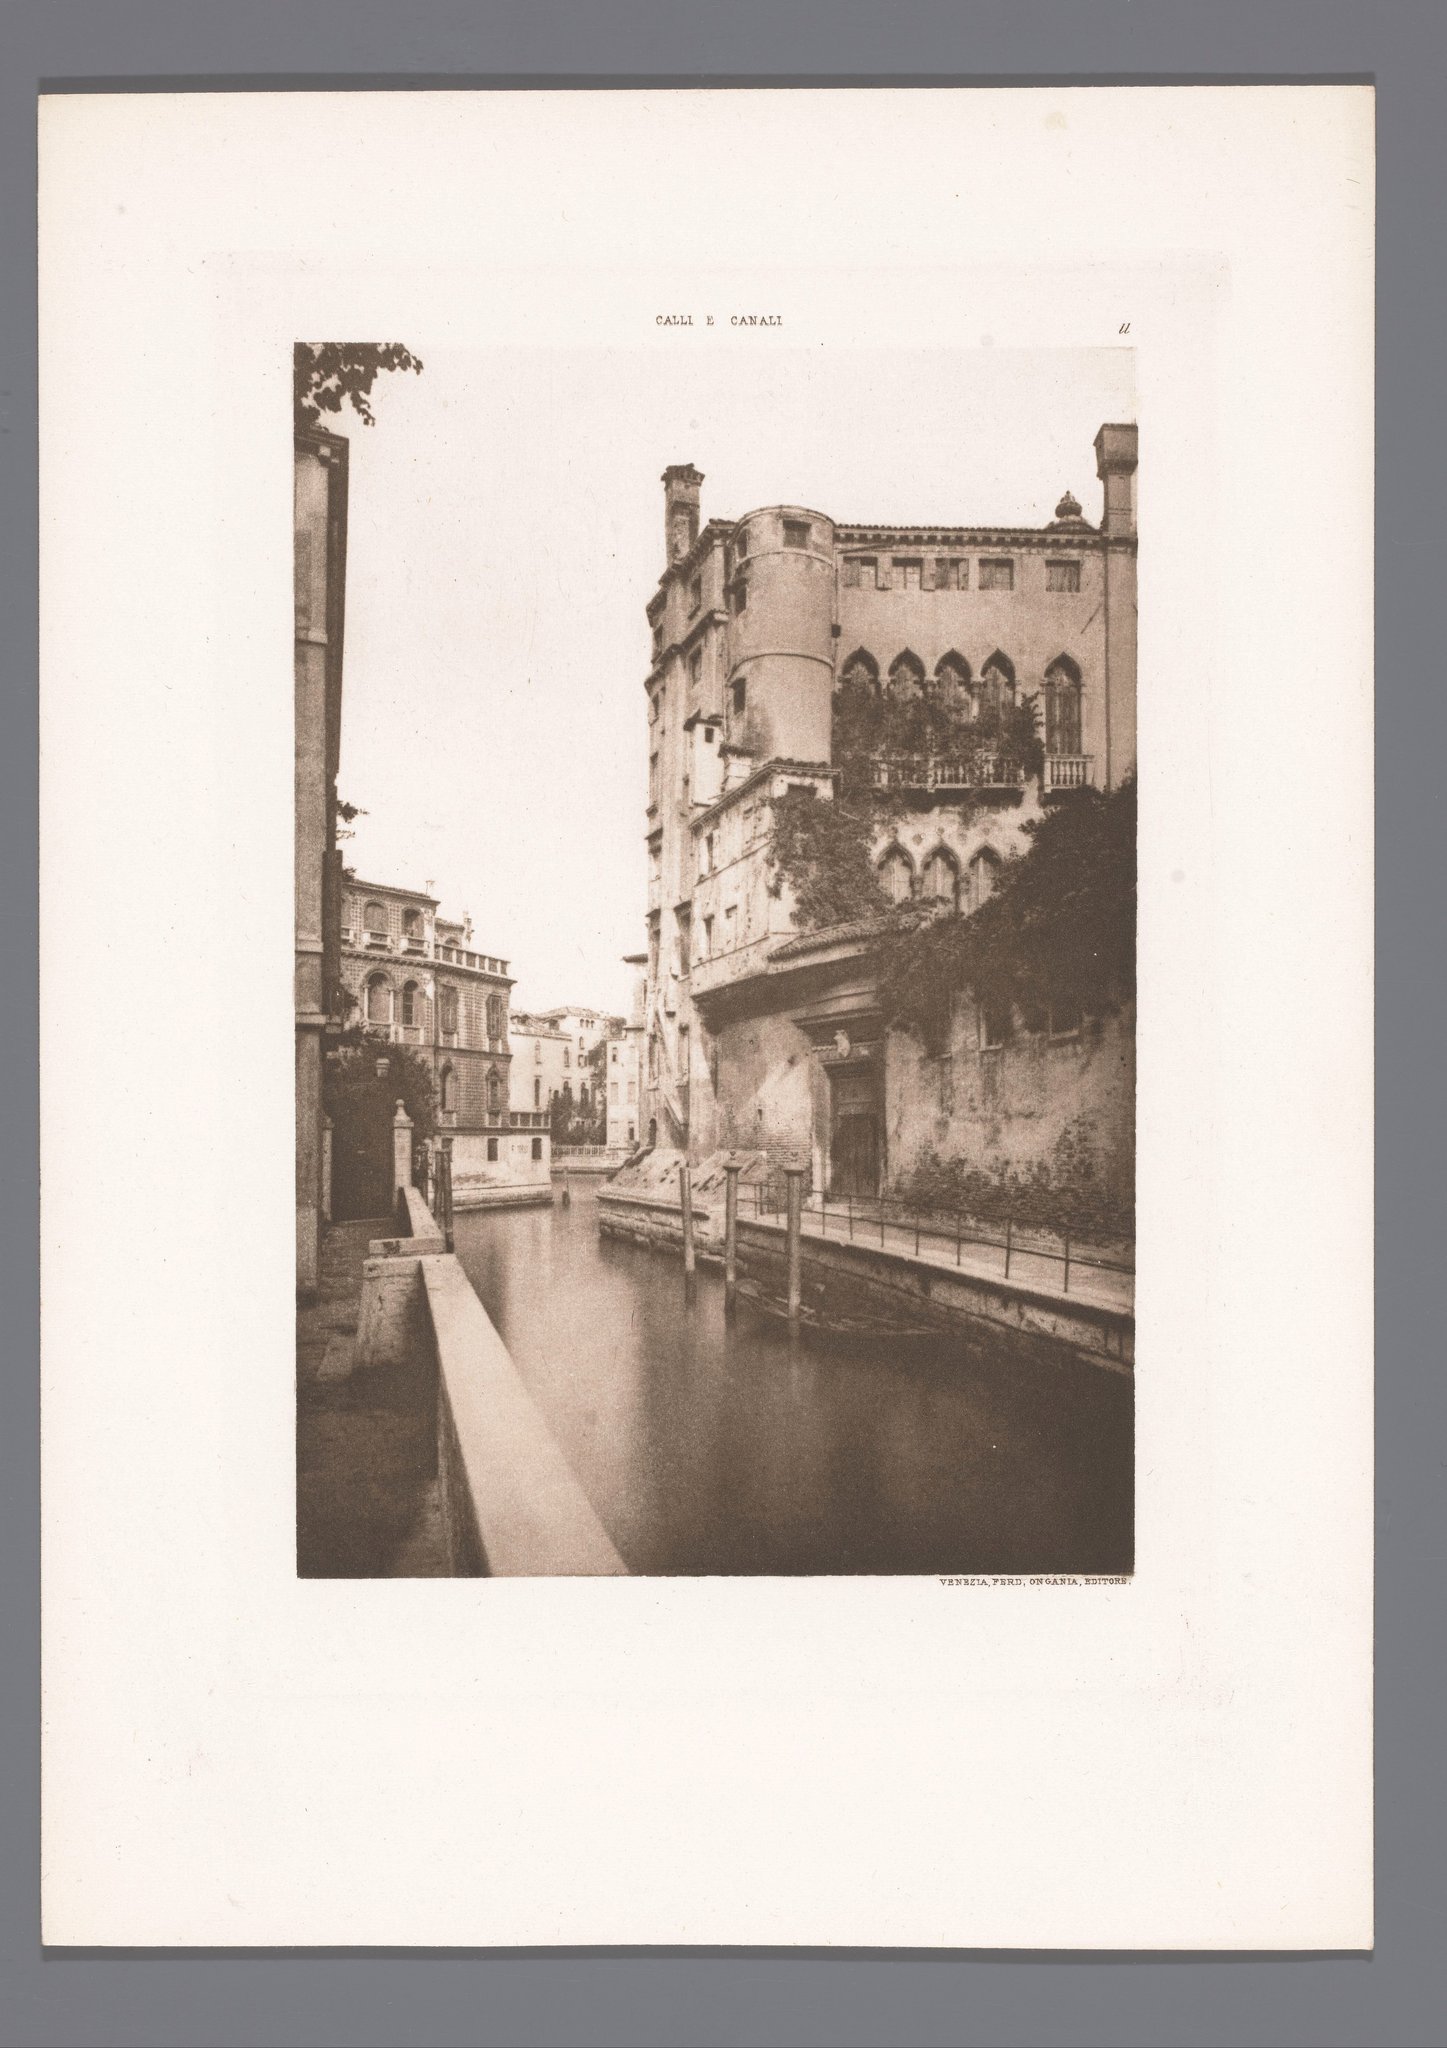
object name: page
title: Calli e canali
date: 1888-1898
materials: paper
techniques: photoaquatint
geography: venice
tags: palace, canals, waters (in city), venice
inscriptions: inscription: ‘ll’